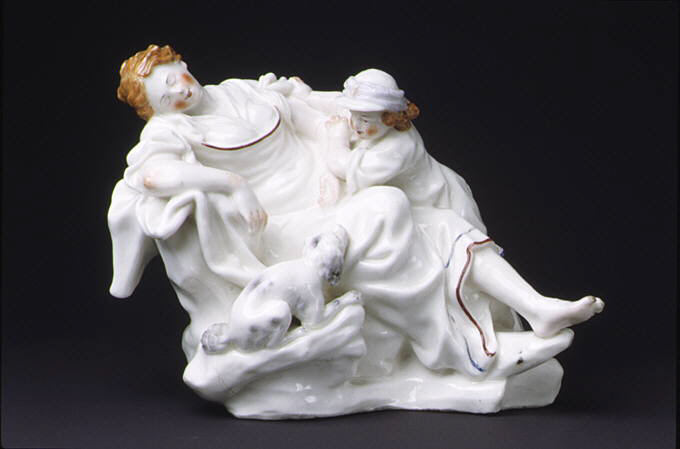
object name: group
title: The Disturbed Slumber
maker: real fabrica de buen retiro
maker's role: factory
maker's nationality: spanish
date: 1760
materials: soft paste porcelain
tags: animals,sleeping,girls,women